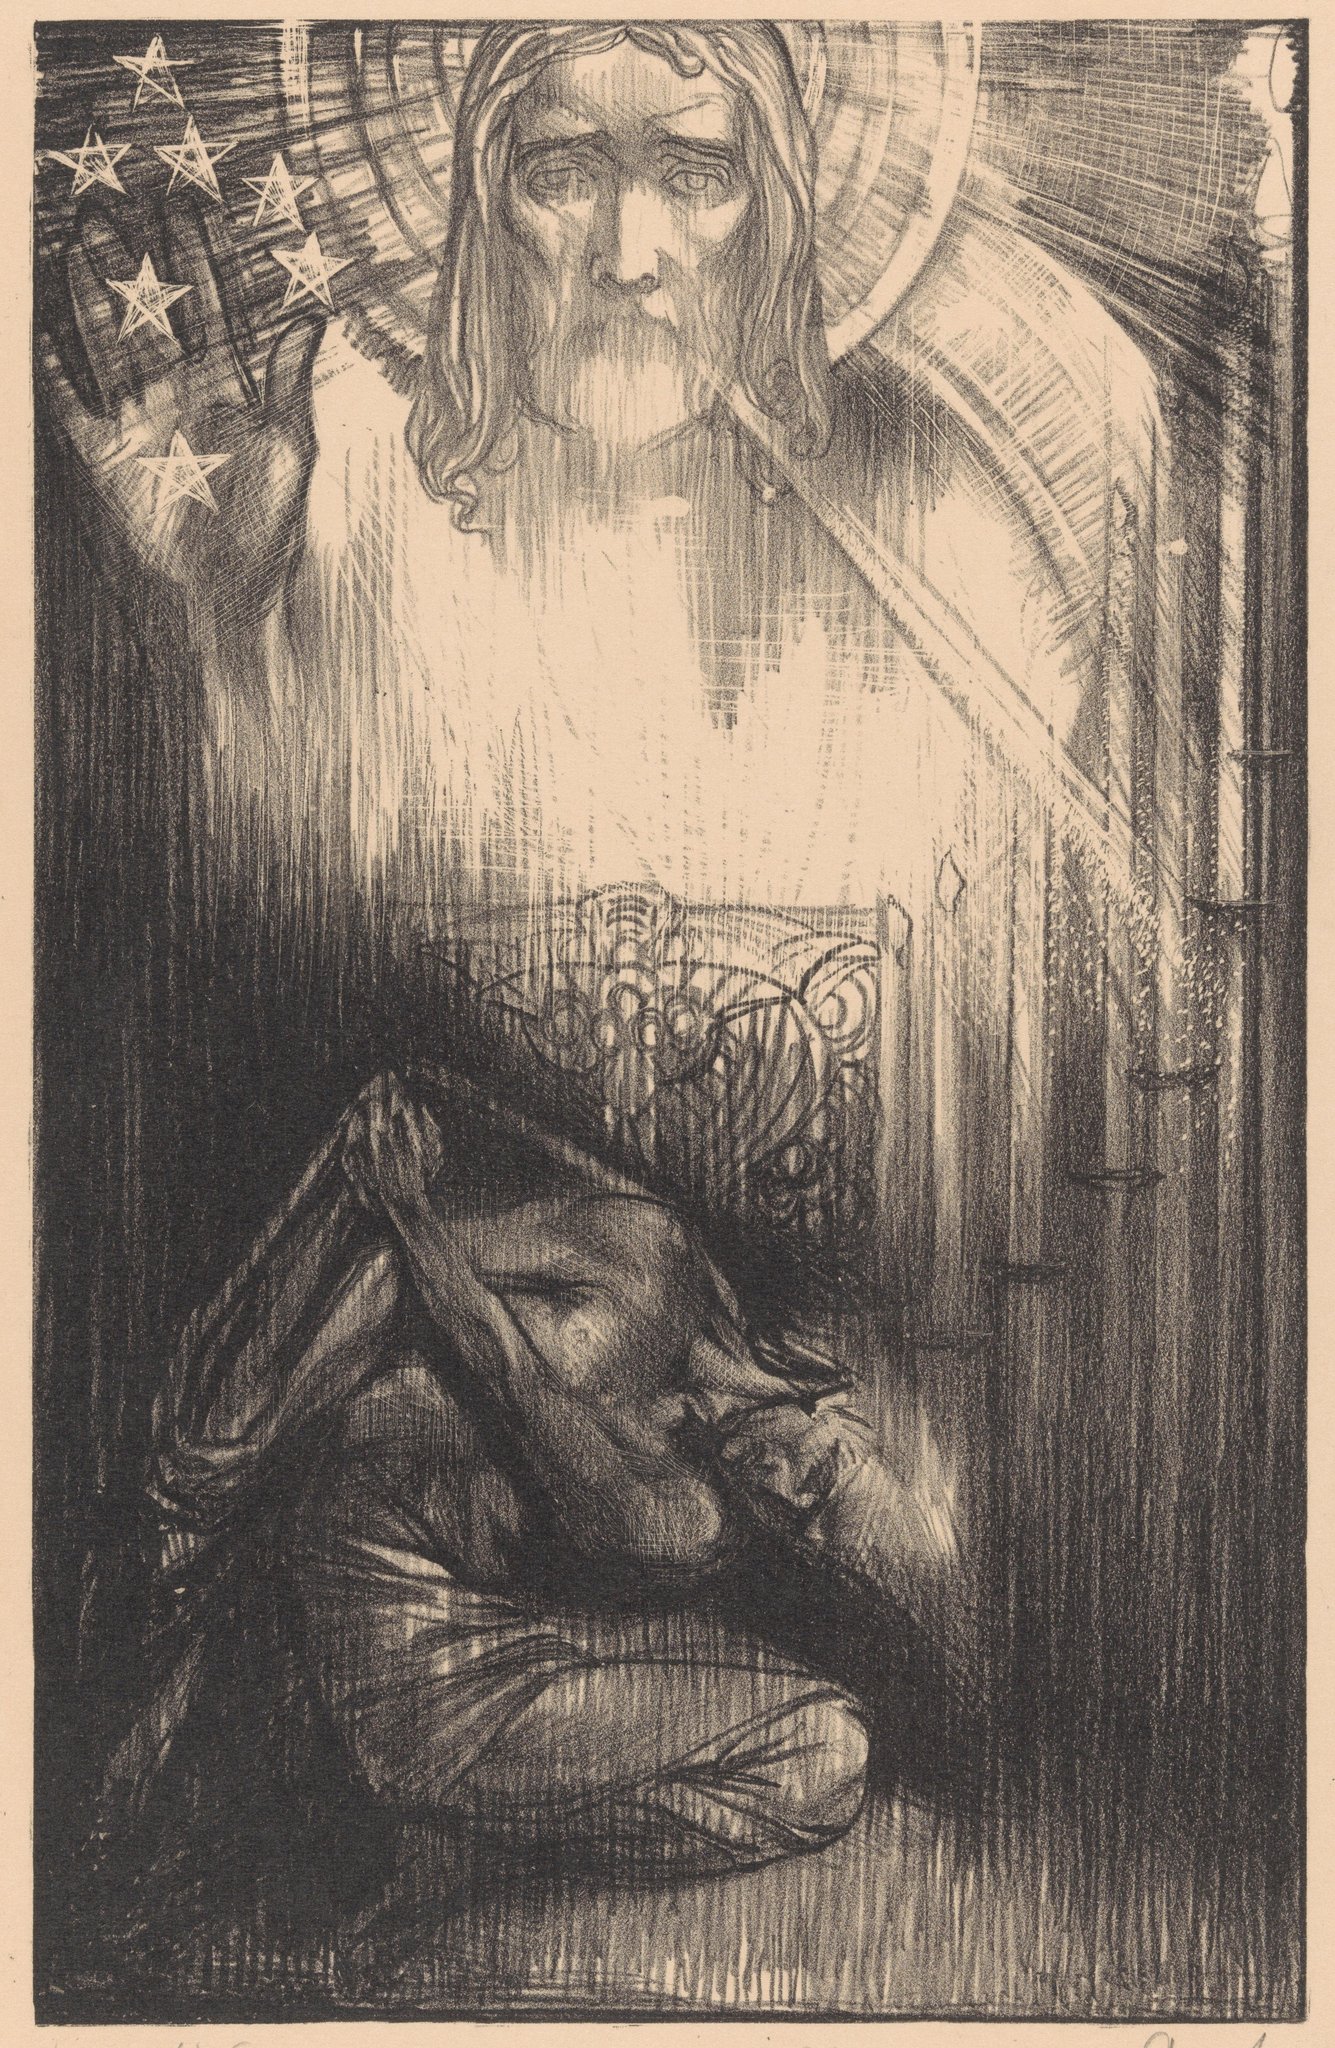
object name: print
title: Verschijning van Christus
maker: johannes josephus aarts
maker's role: draughtsman, print maker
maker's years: 1871-1934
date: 1927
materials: paper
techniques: lithograph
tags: nimbus, halo ~ radiance emanating from persons or things, christ between seven golden candlesticks appears to john, who falls to the ground; a sword comes out of christ's mouth and he holds seven stars in his hands, christ, sitting on the ground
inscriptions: collector's mark: Lugt 2228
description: Christus verschijnt aan Johannes, die op de grond voor hem is neergevallen. Uit de mond van Christus komt een zwaard en uit zijn rechterhand zeven sterren. Rechts bevinden zich zeven lampenstandaards. Een verbeelding van een scène uit het Bijbelboek Openbaring (1:12-17).